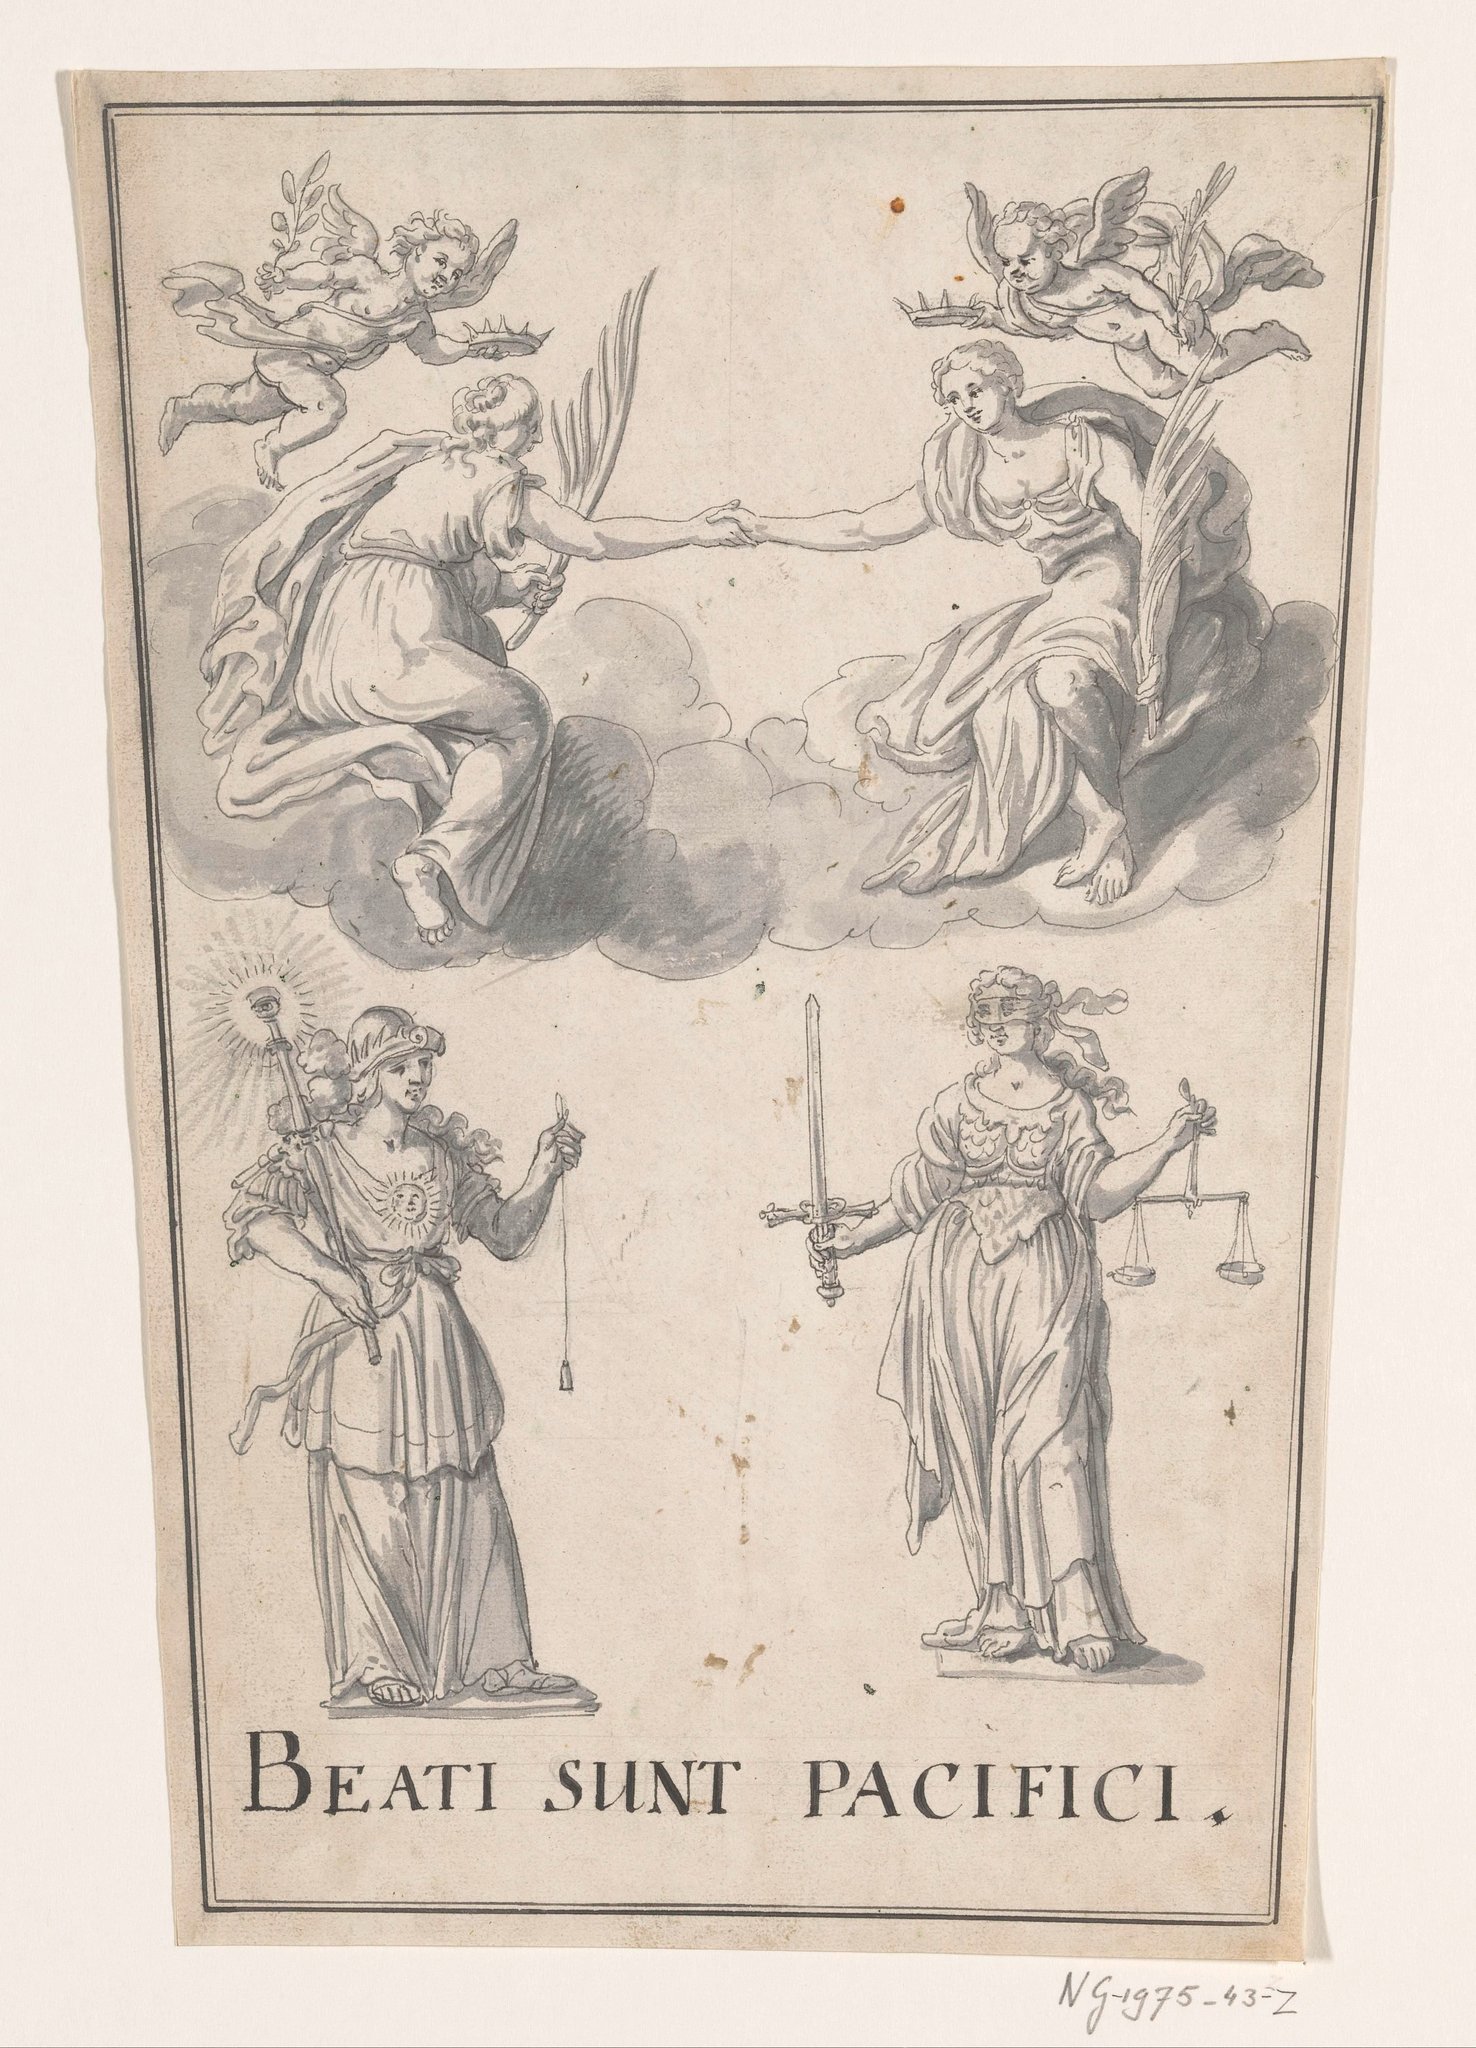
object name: drawing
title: Allegorisch embleem bij de Vrede van Rijswijk, 1697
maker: Anonymous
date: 1697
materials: ink, paper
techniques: brush, pen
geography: northern netherlands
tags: justice, 'justitia'; 'giustitia divina' (ripa) ~ one of the four cardinal virtues, symbols, allegories of peace, 'pax'; 'pace' (ripa), festivities on events of national importance (+ festive decoration ~ festive activities)